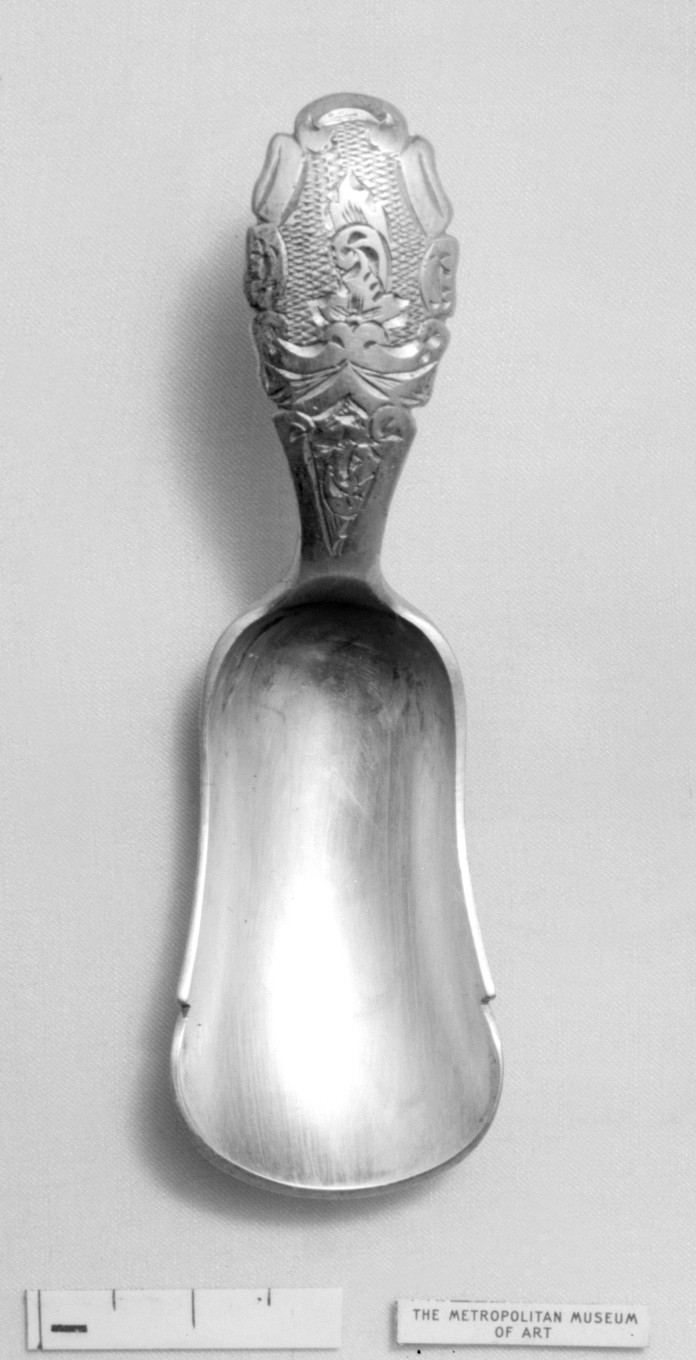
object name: caddy spoon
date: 1801-1833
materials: silver